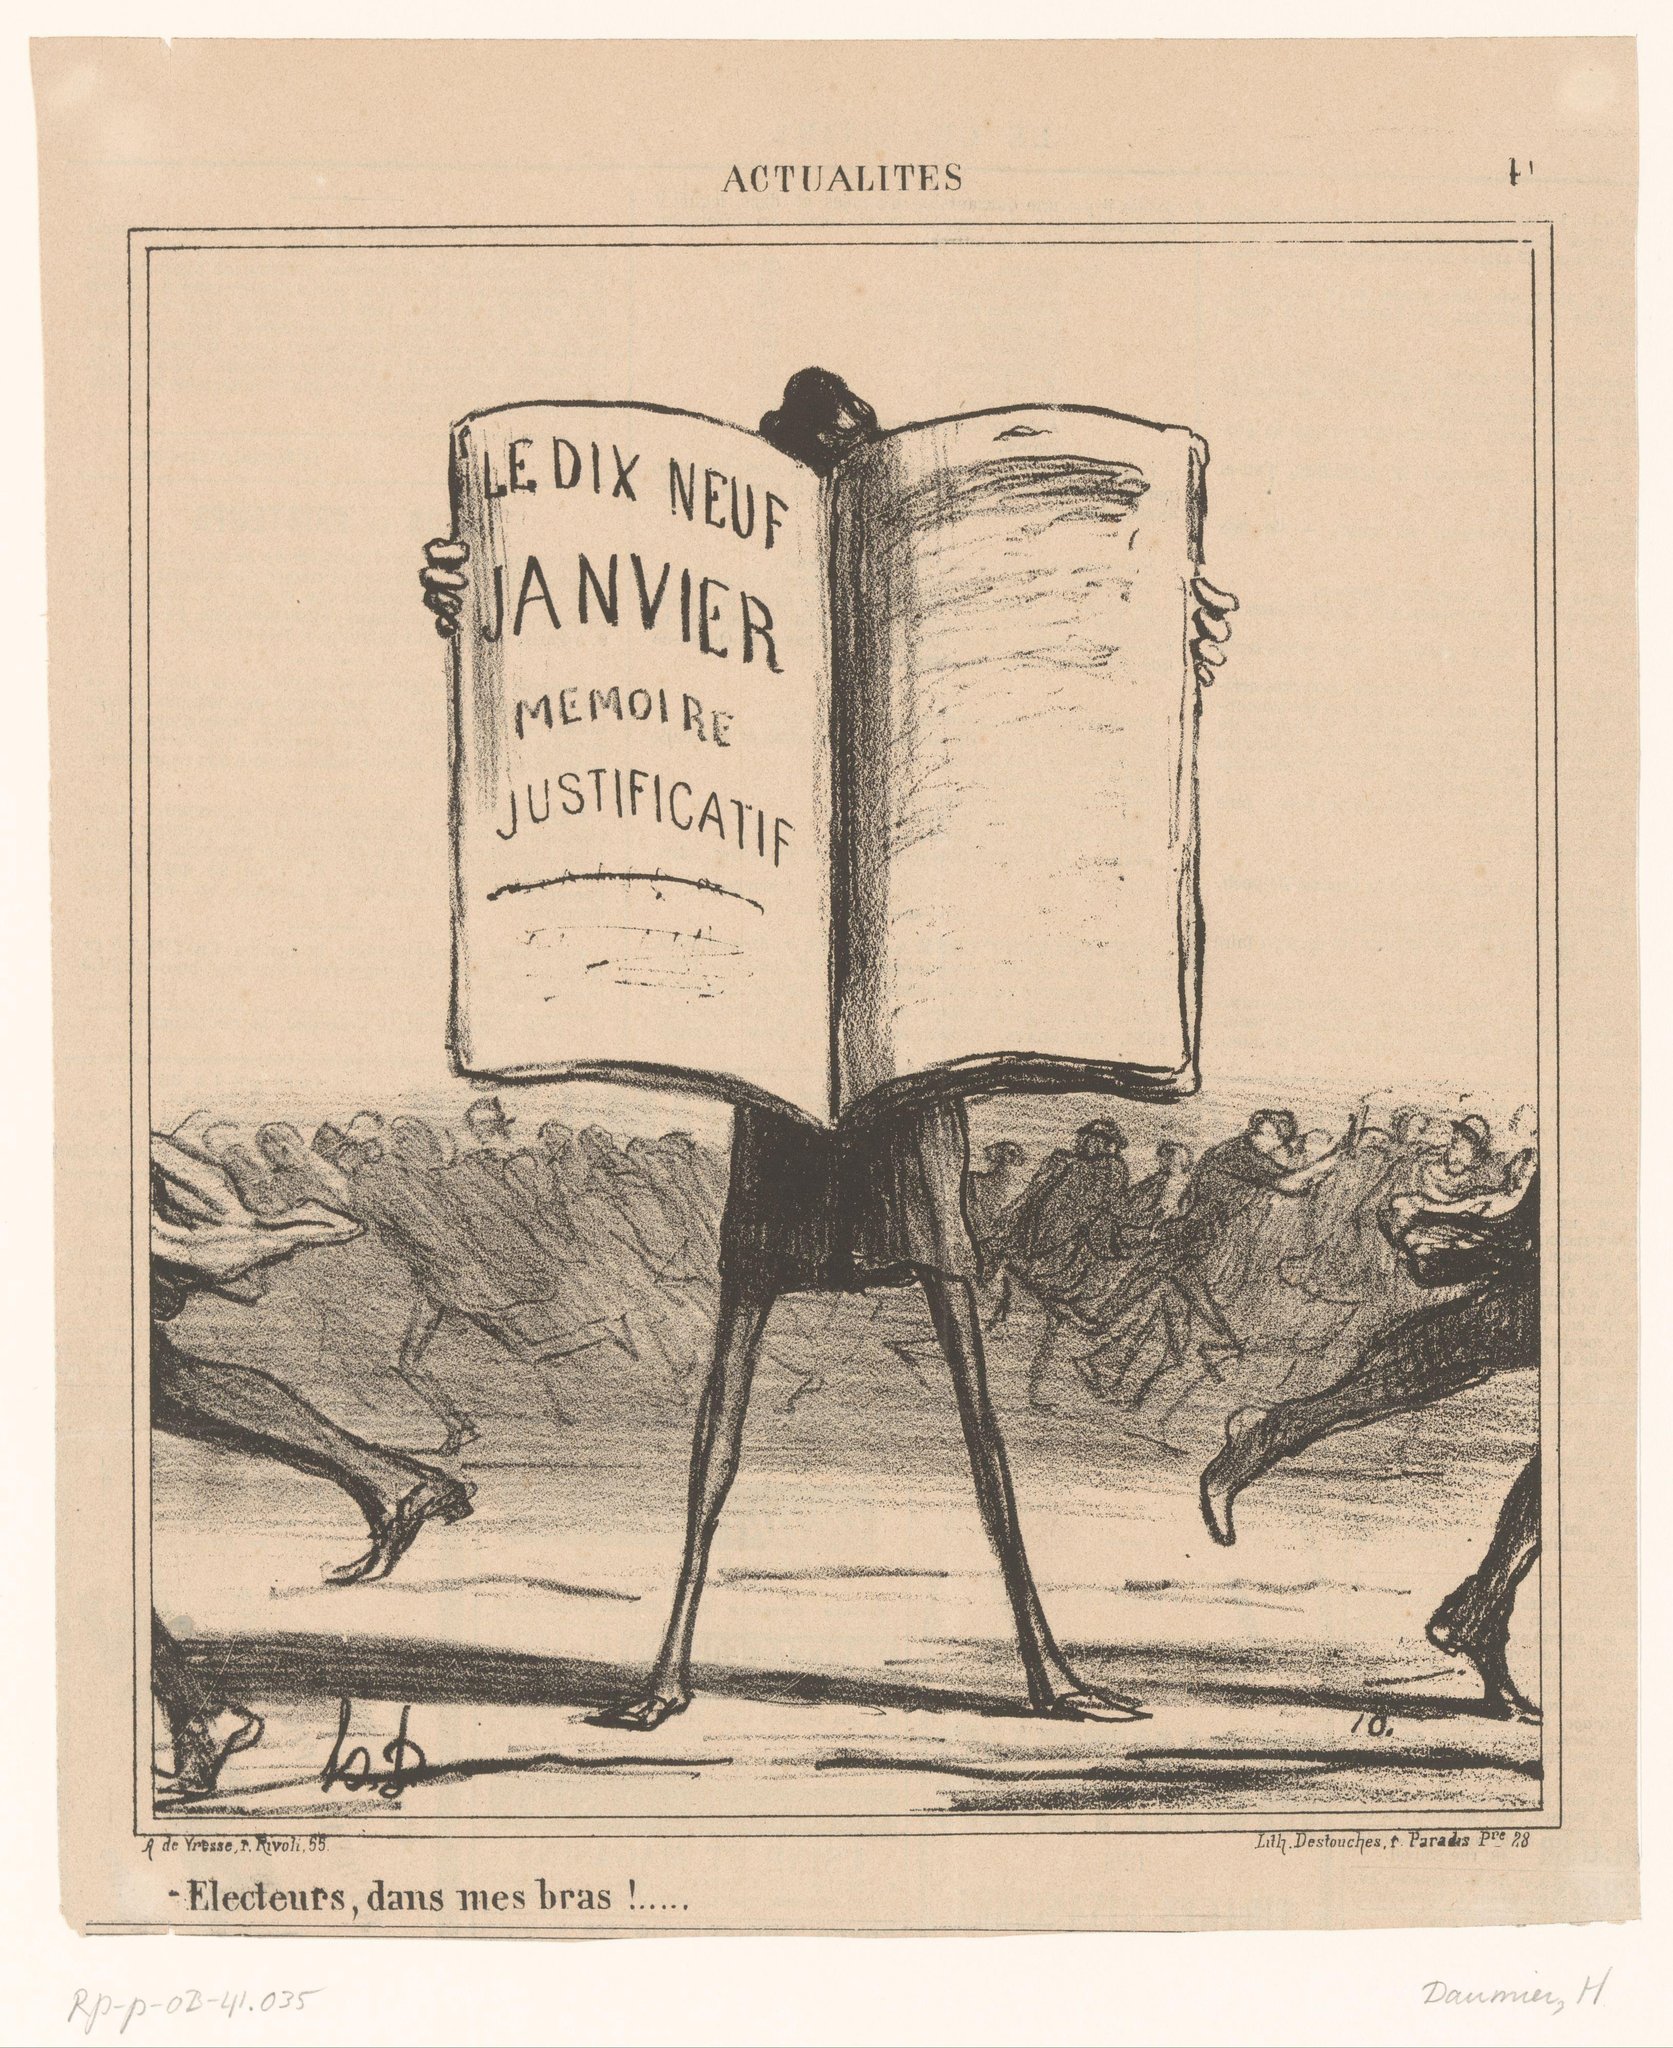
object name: cartoon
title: Electeurs, dans mes bras!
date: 1869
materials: paper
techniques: lithograph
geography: paris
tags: marseille, politician, caricatures (human types), historical persons, political caricatures and satires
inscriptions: collector's mark: Lugt 2228a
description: Prent gebruikt voor: Le Charivari, 10 maart 1869.